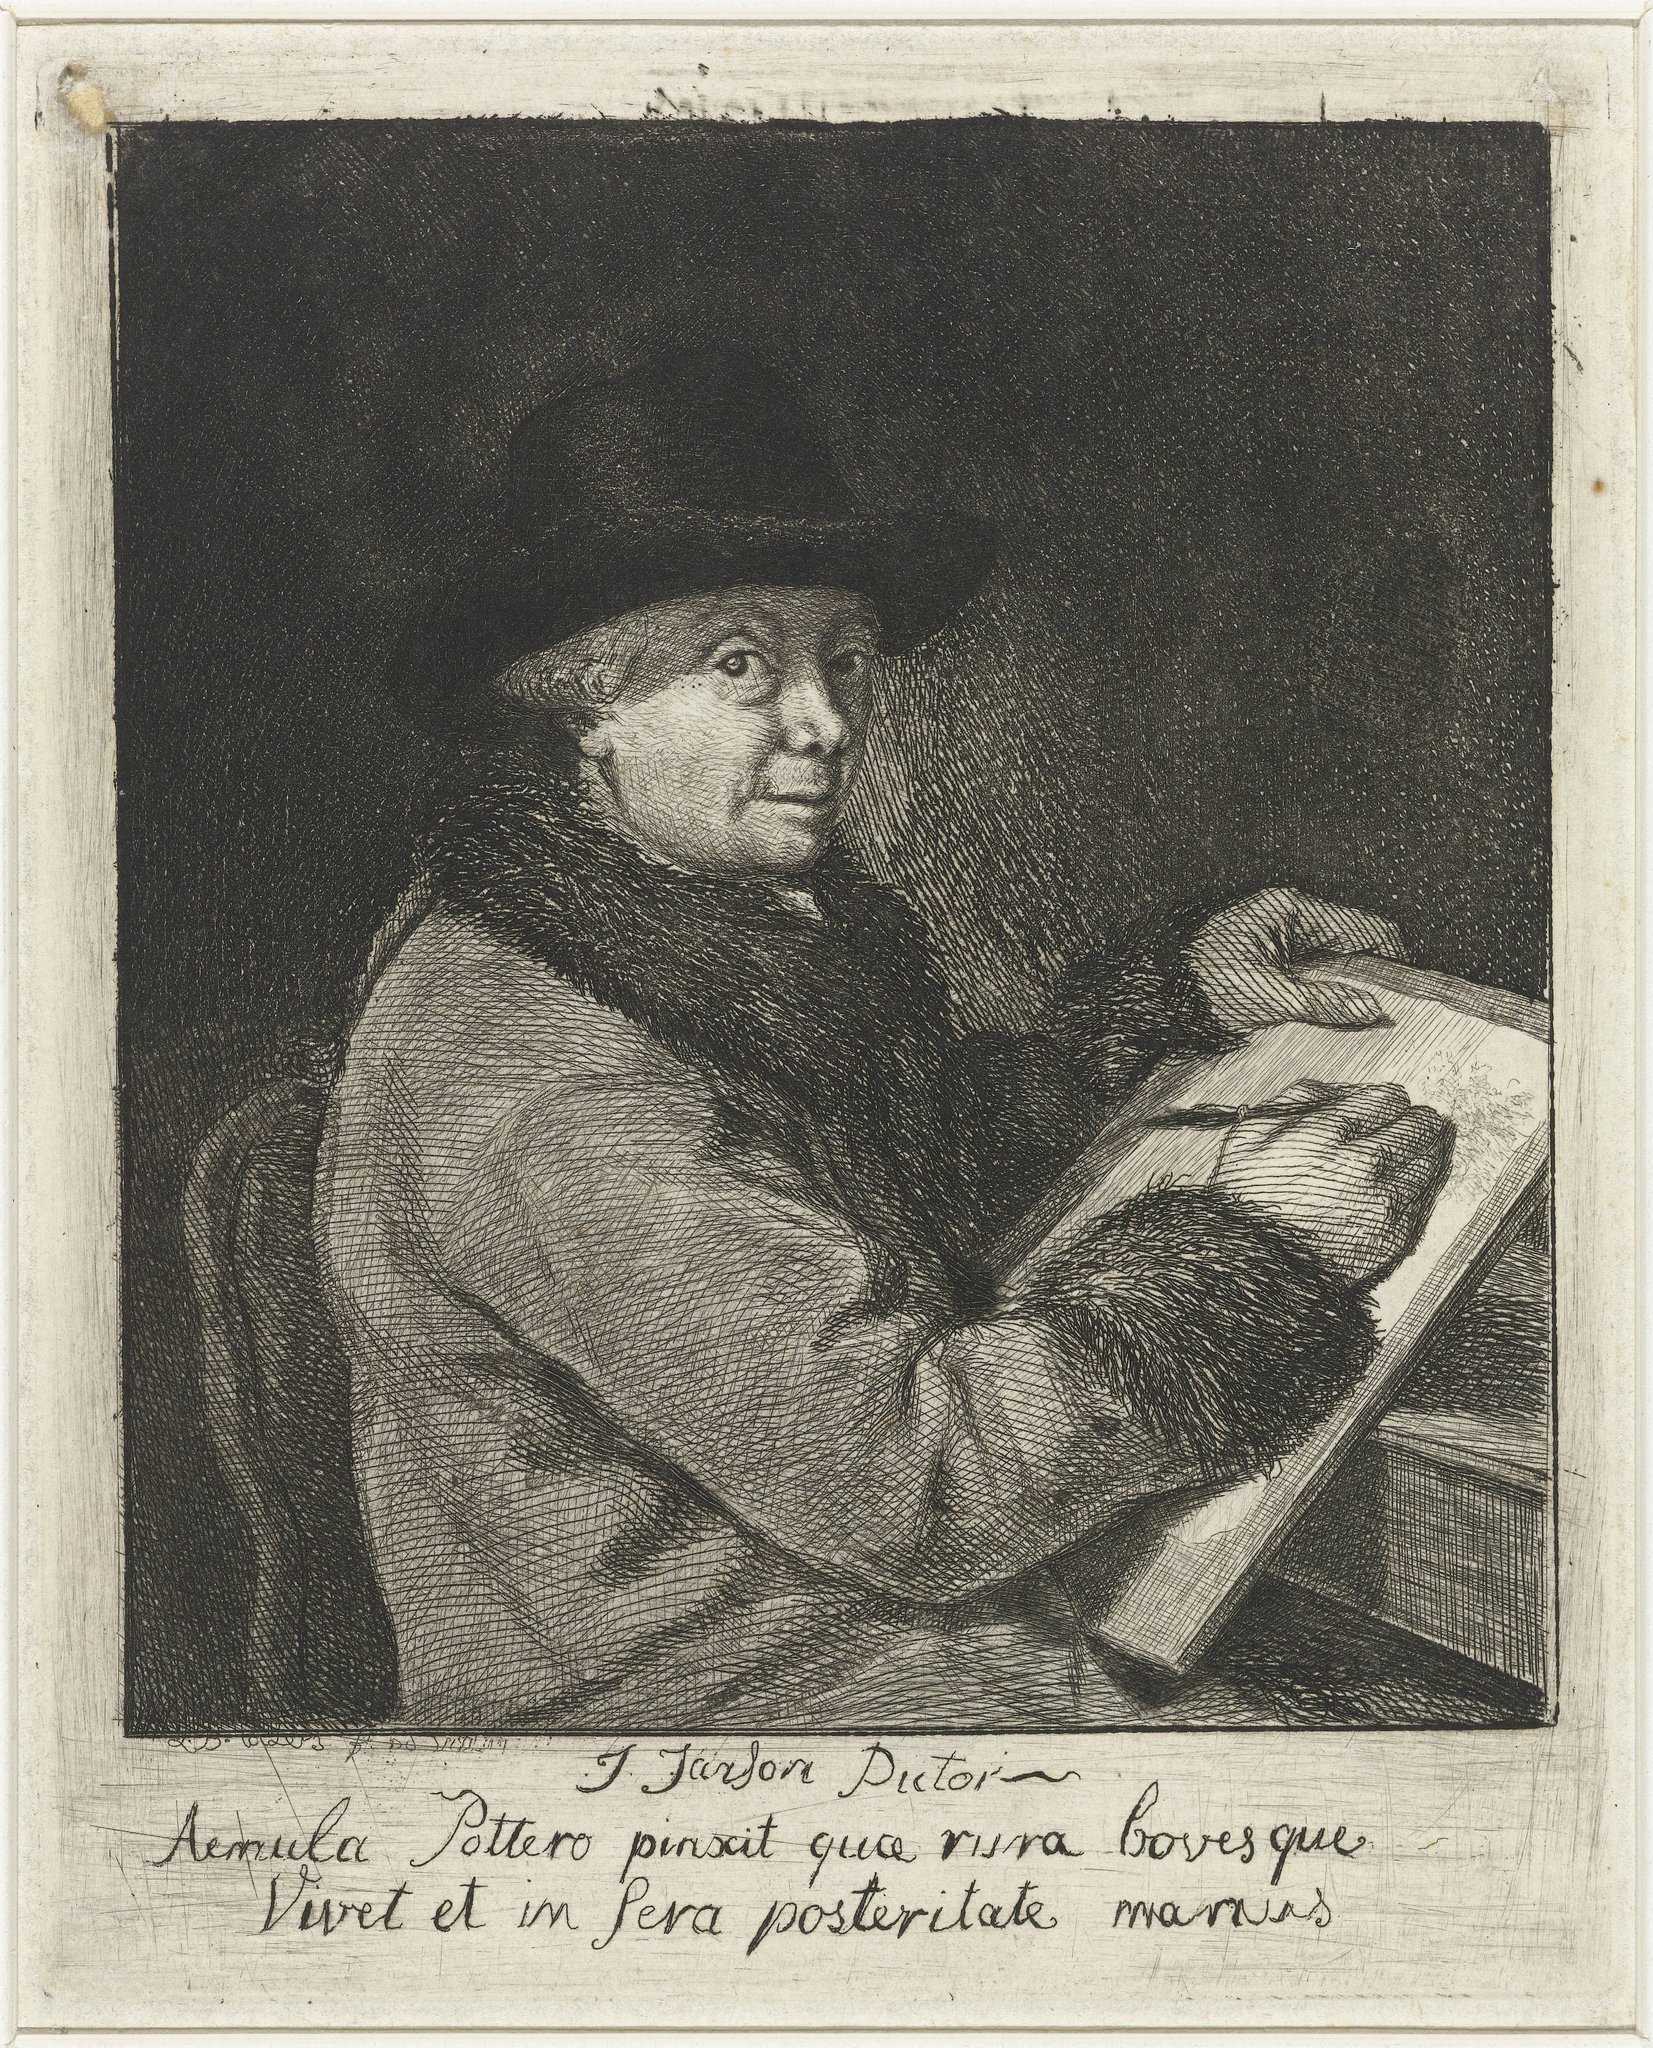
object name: print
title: Portret van de kunstenaar Johannes Janson, tekenend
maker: louis bernard coclers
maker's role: draughtsman, print maker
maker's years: 1741-1817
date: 1769-1787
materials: paper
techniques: drypoint, etching, intaglio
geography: leiden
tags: leiden, painter, draughtsman, johannes janson, portrait, self-portrait of artist (+ making preliminary designs, sketching)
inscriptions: collector's mark: Lugt 2228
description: Johannes Janson zittend in zijn atelier met en tekenplank in de hand. Janson draagt een hoed en een mantel met bontkraag. Onder het portret een Latijns vers.